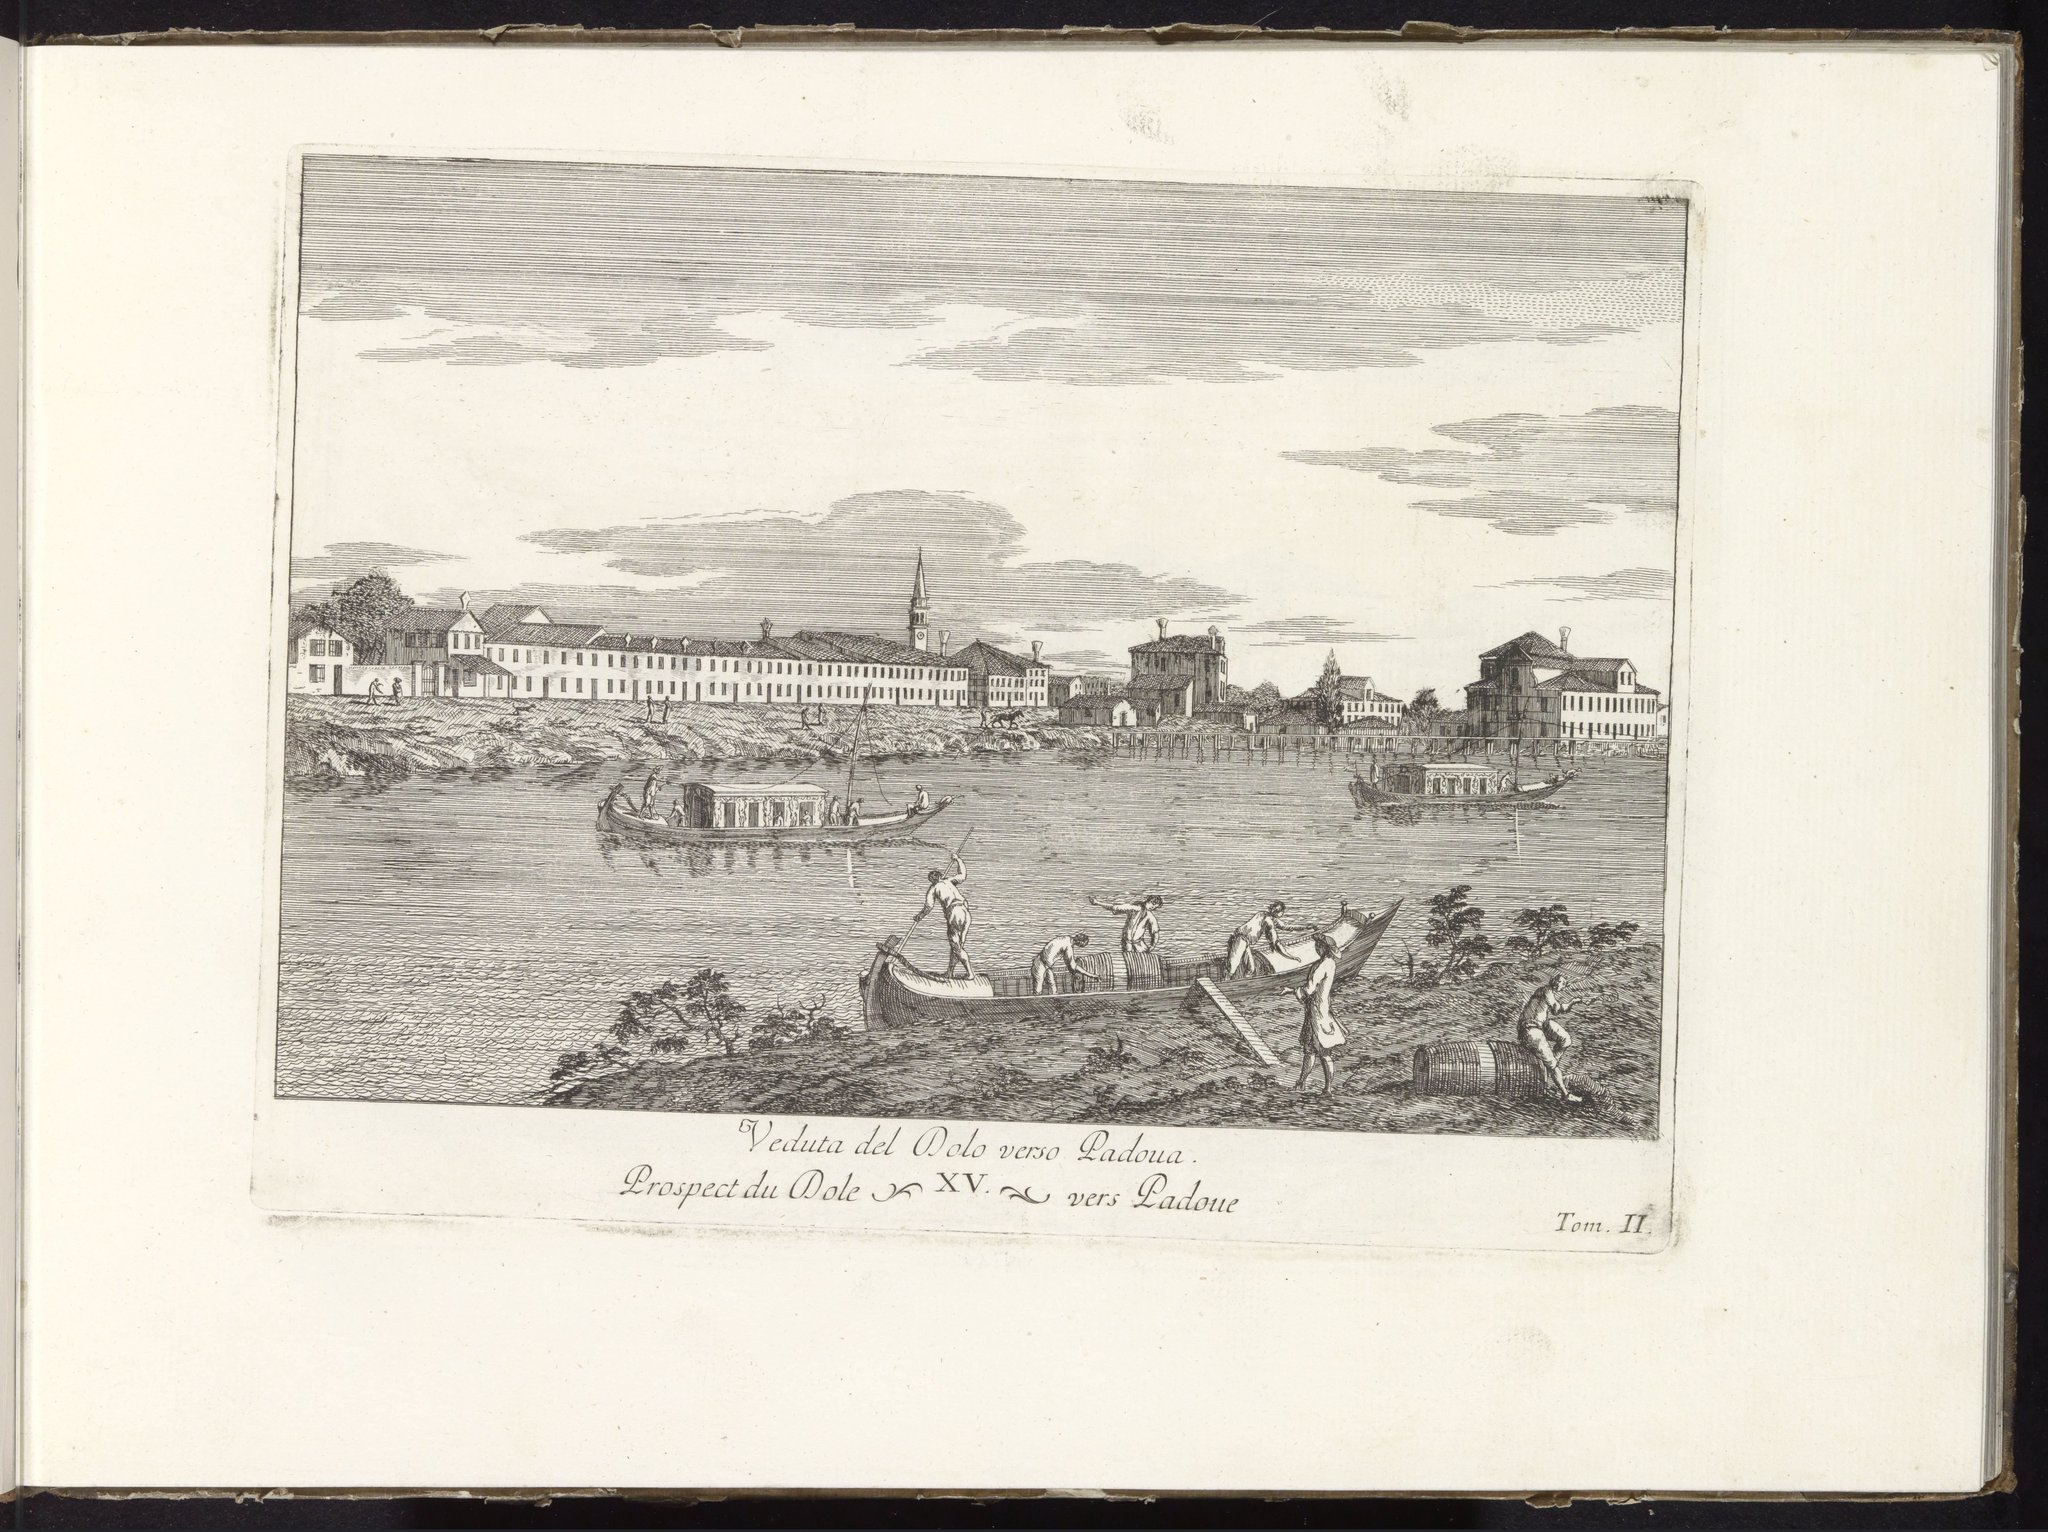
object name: print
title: Veduta del Dolo verso Padov (...)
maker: giovanni francesco costa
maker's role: draughtsman, painter, print maker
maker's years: -1773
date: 1750-1760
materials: paper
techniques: etching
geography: venice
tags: river, gondola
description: Gezicht op Dolo richting Padua. Op de voorgrond stroomt de rivier de Brenta. Op het water varen gondels. Op de voorgrond ligt een gondel aangemeerd. Genummerd midden onder: XV en rechtsonder: Tom: II. Deze prent maakt deel uit van een album.